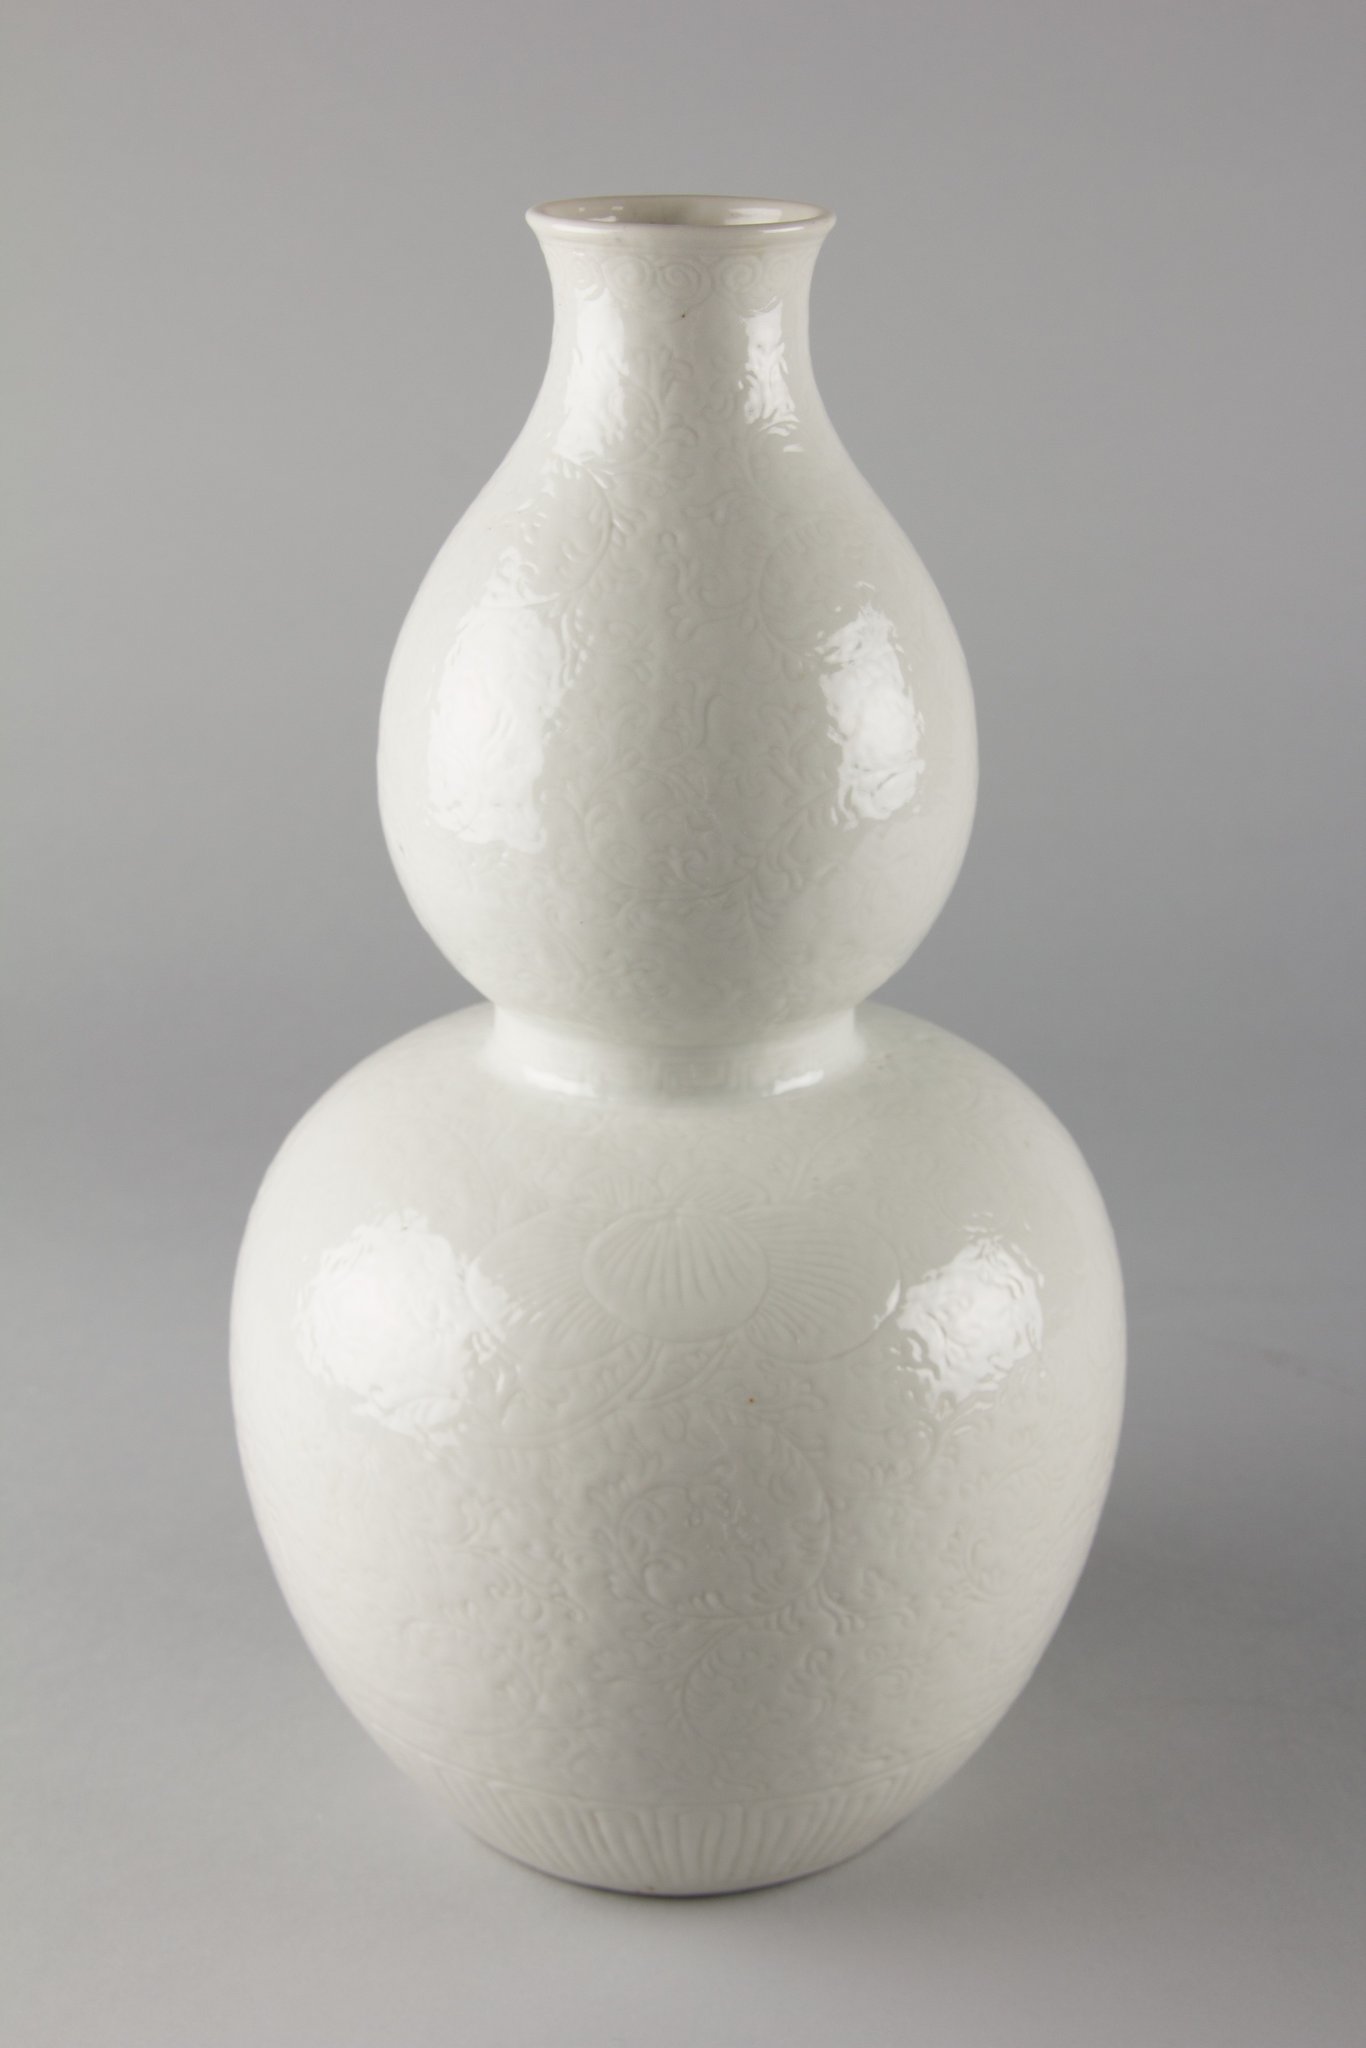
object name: vase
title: Gourd-Shaped Vase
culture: chinese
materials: glaze, porcelain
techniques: incising